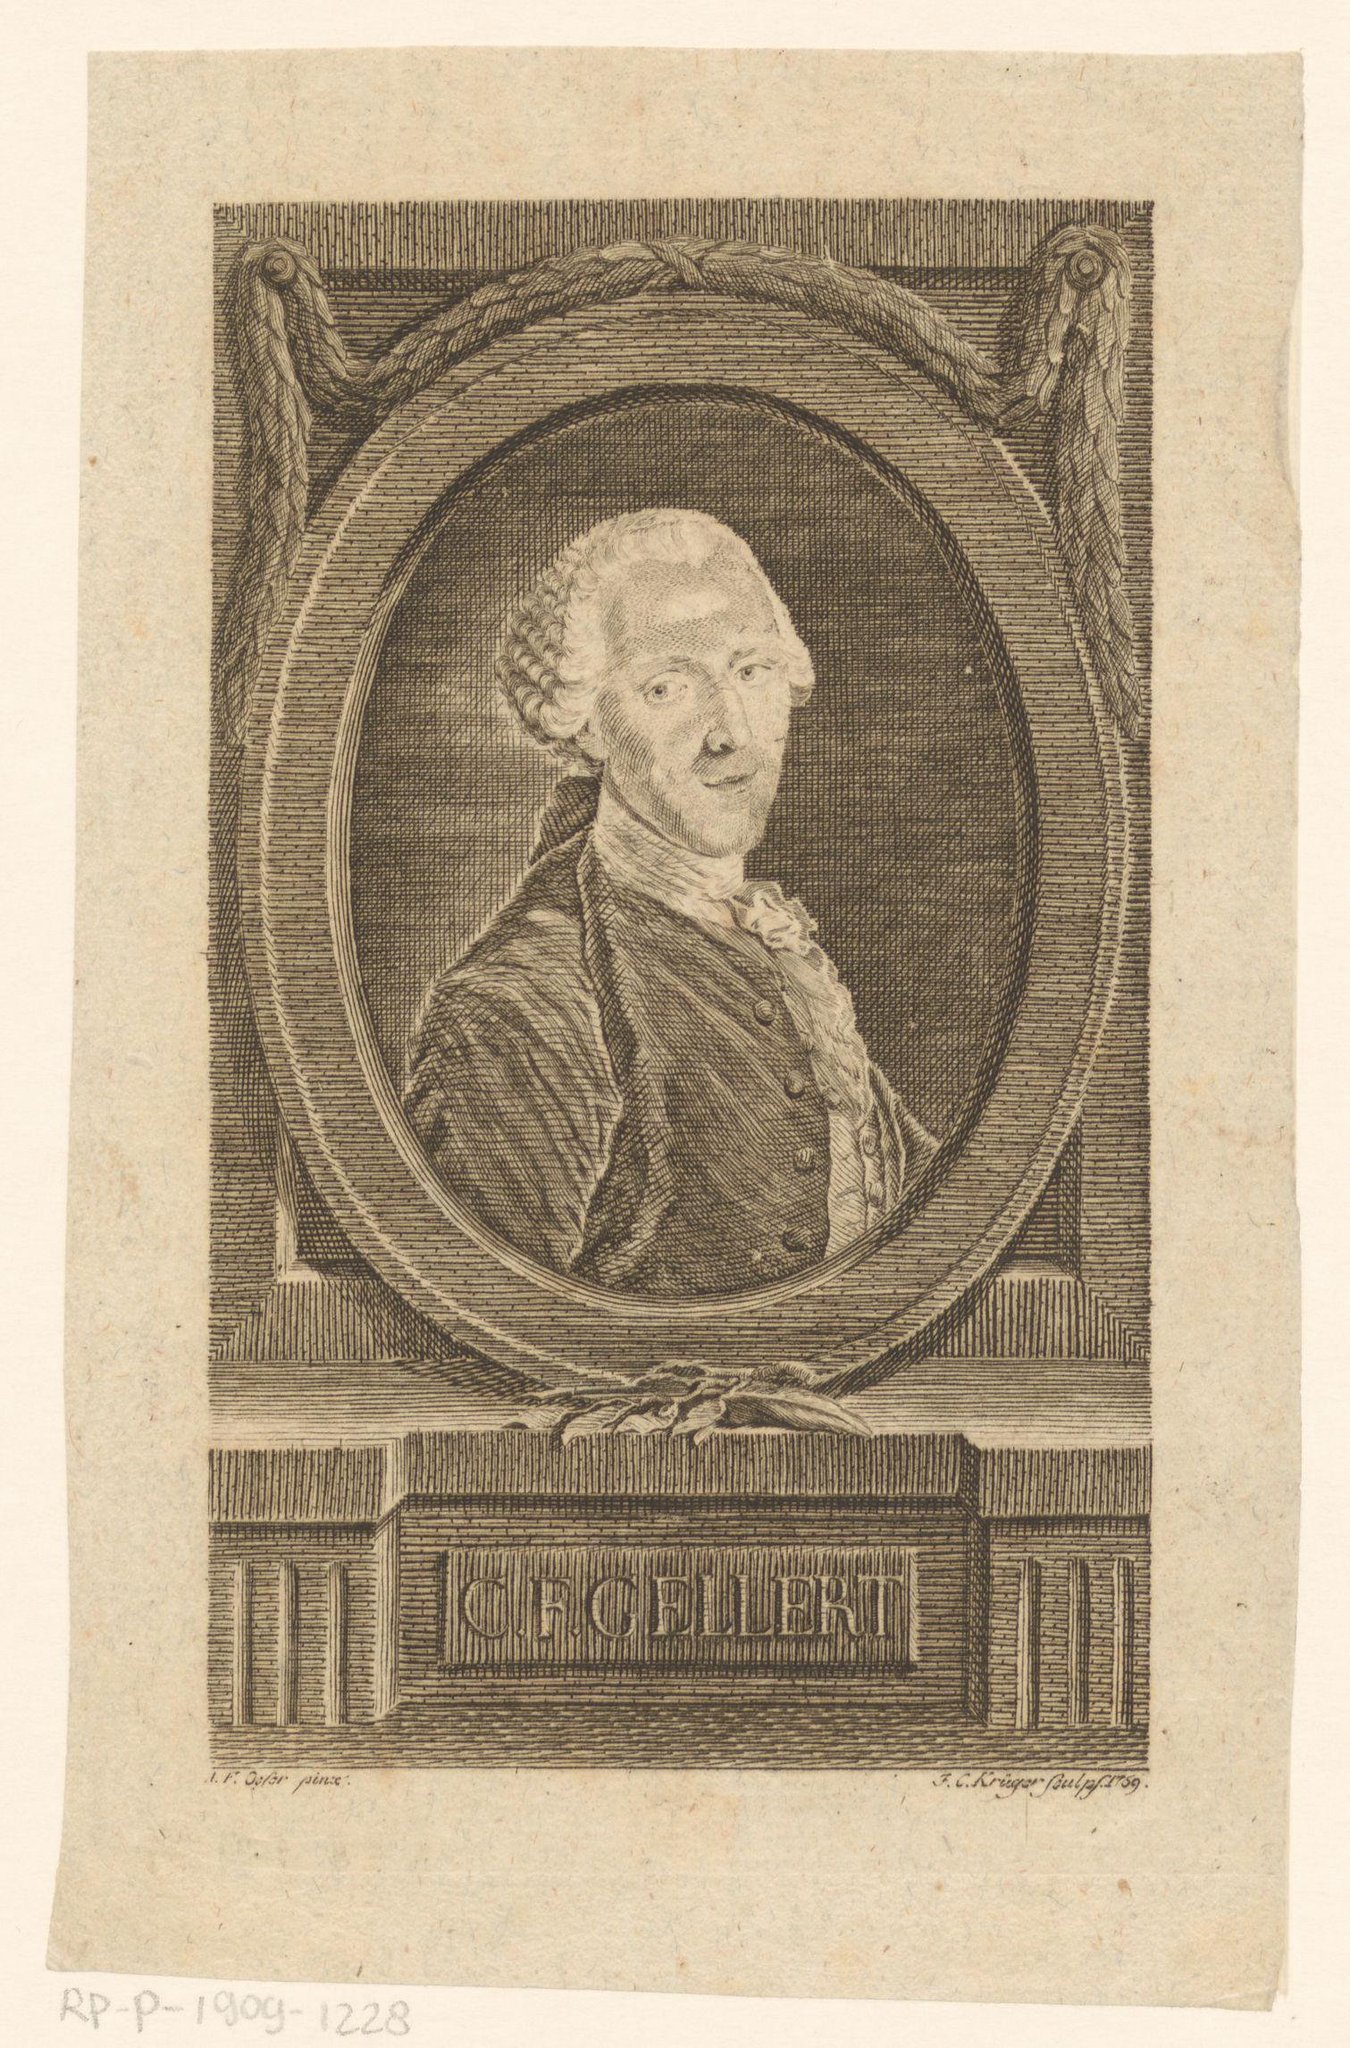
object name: print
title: Portret van Christian Fürchtegott Gellert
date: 1769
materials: paper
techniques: engraving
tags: historical persons, scholar, philosopher (+ portrait of scholar, scientist)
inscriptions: collector's mark: Lugt 2228